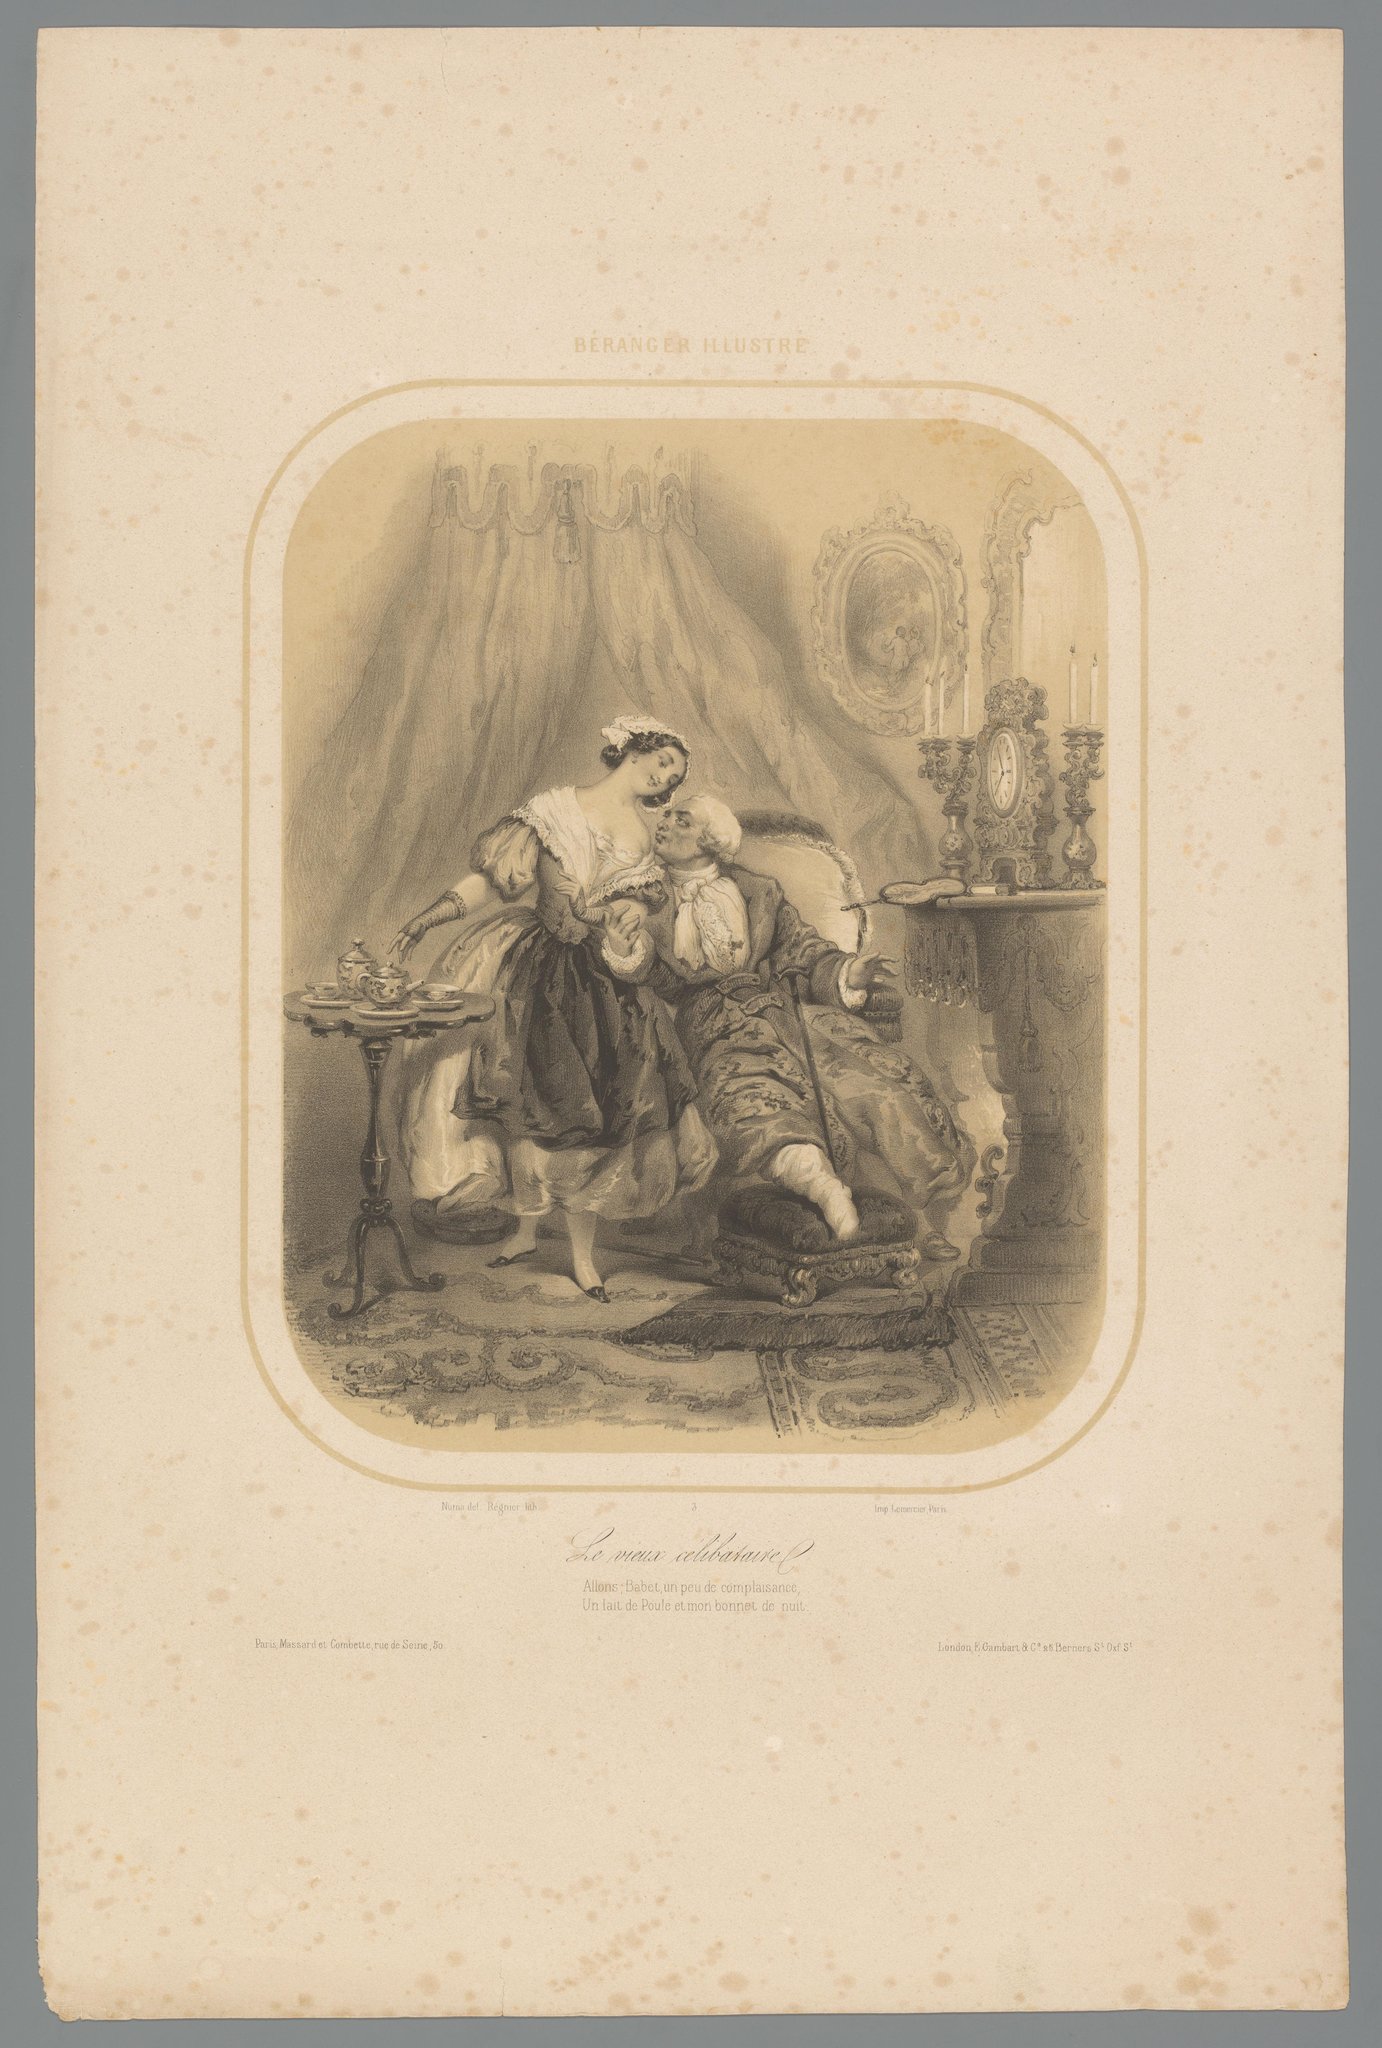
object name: print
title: Le vieux célibataire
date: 1851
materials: paper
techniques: tone lithography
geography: paris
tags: adolescent, young woman, maiden, old man, foot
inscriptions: collector's mark: Lugt 2228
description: Onderschrift: Allons, Babet, un peu de complaisance, un lait de poule et mon bonnet de nuit.